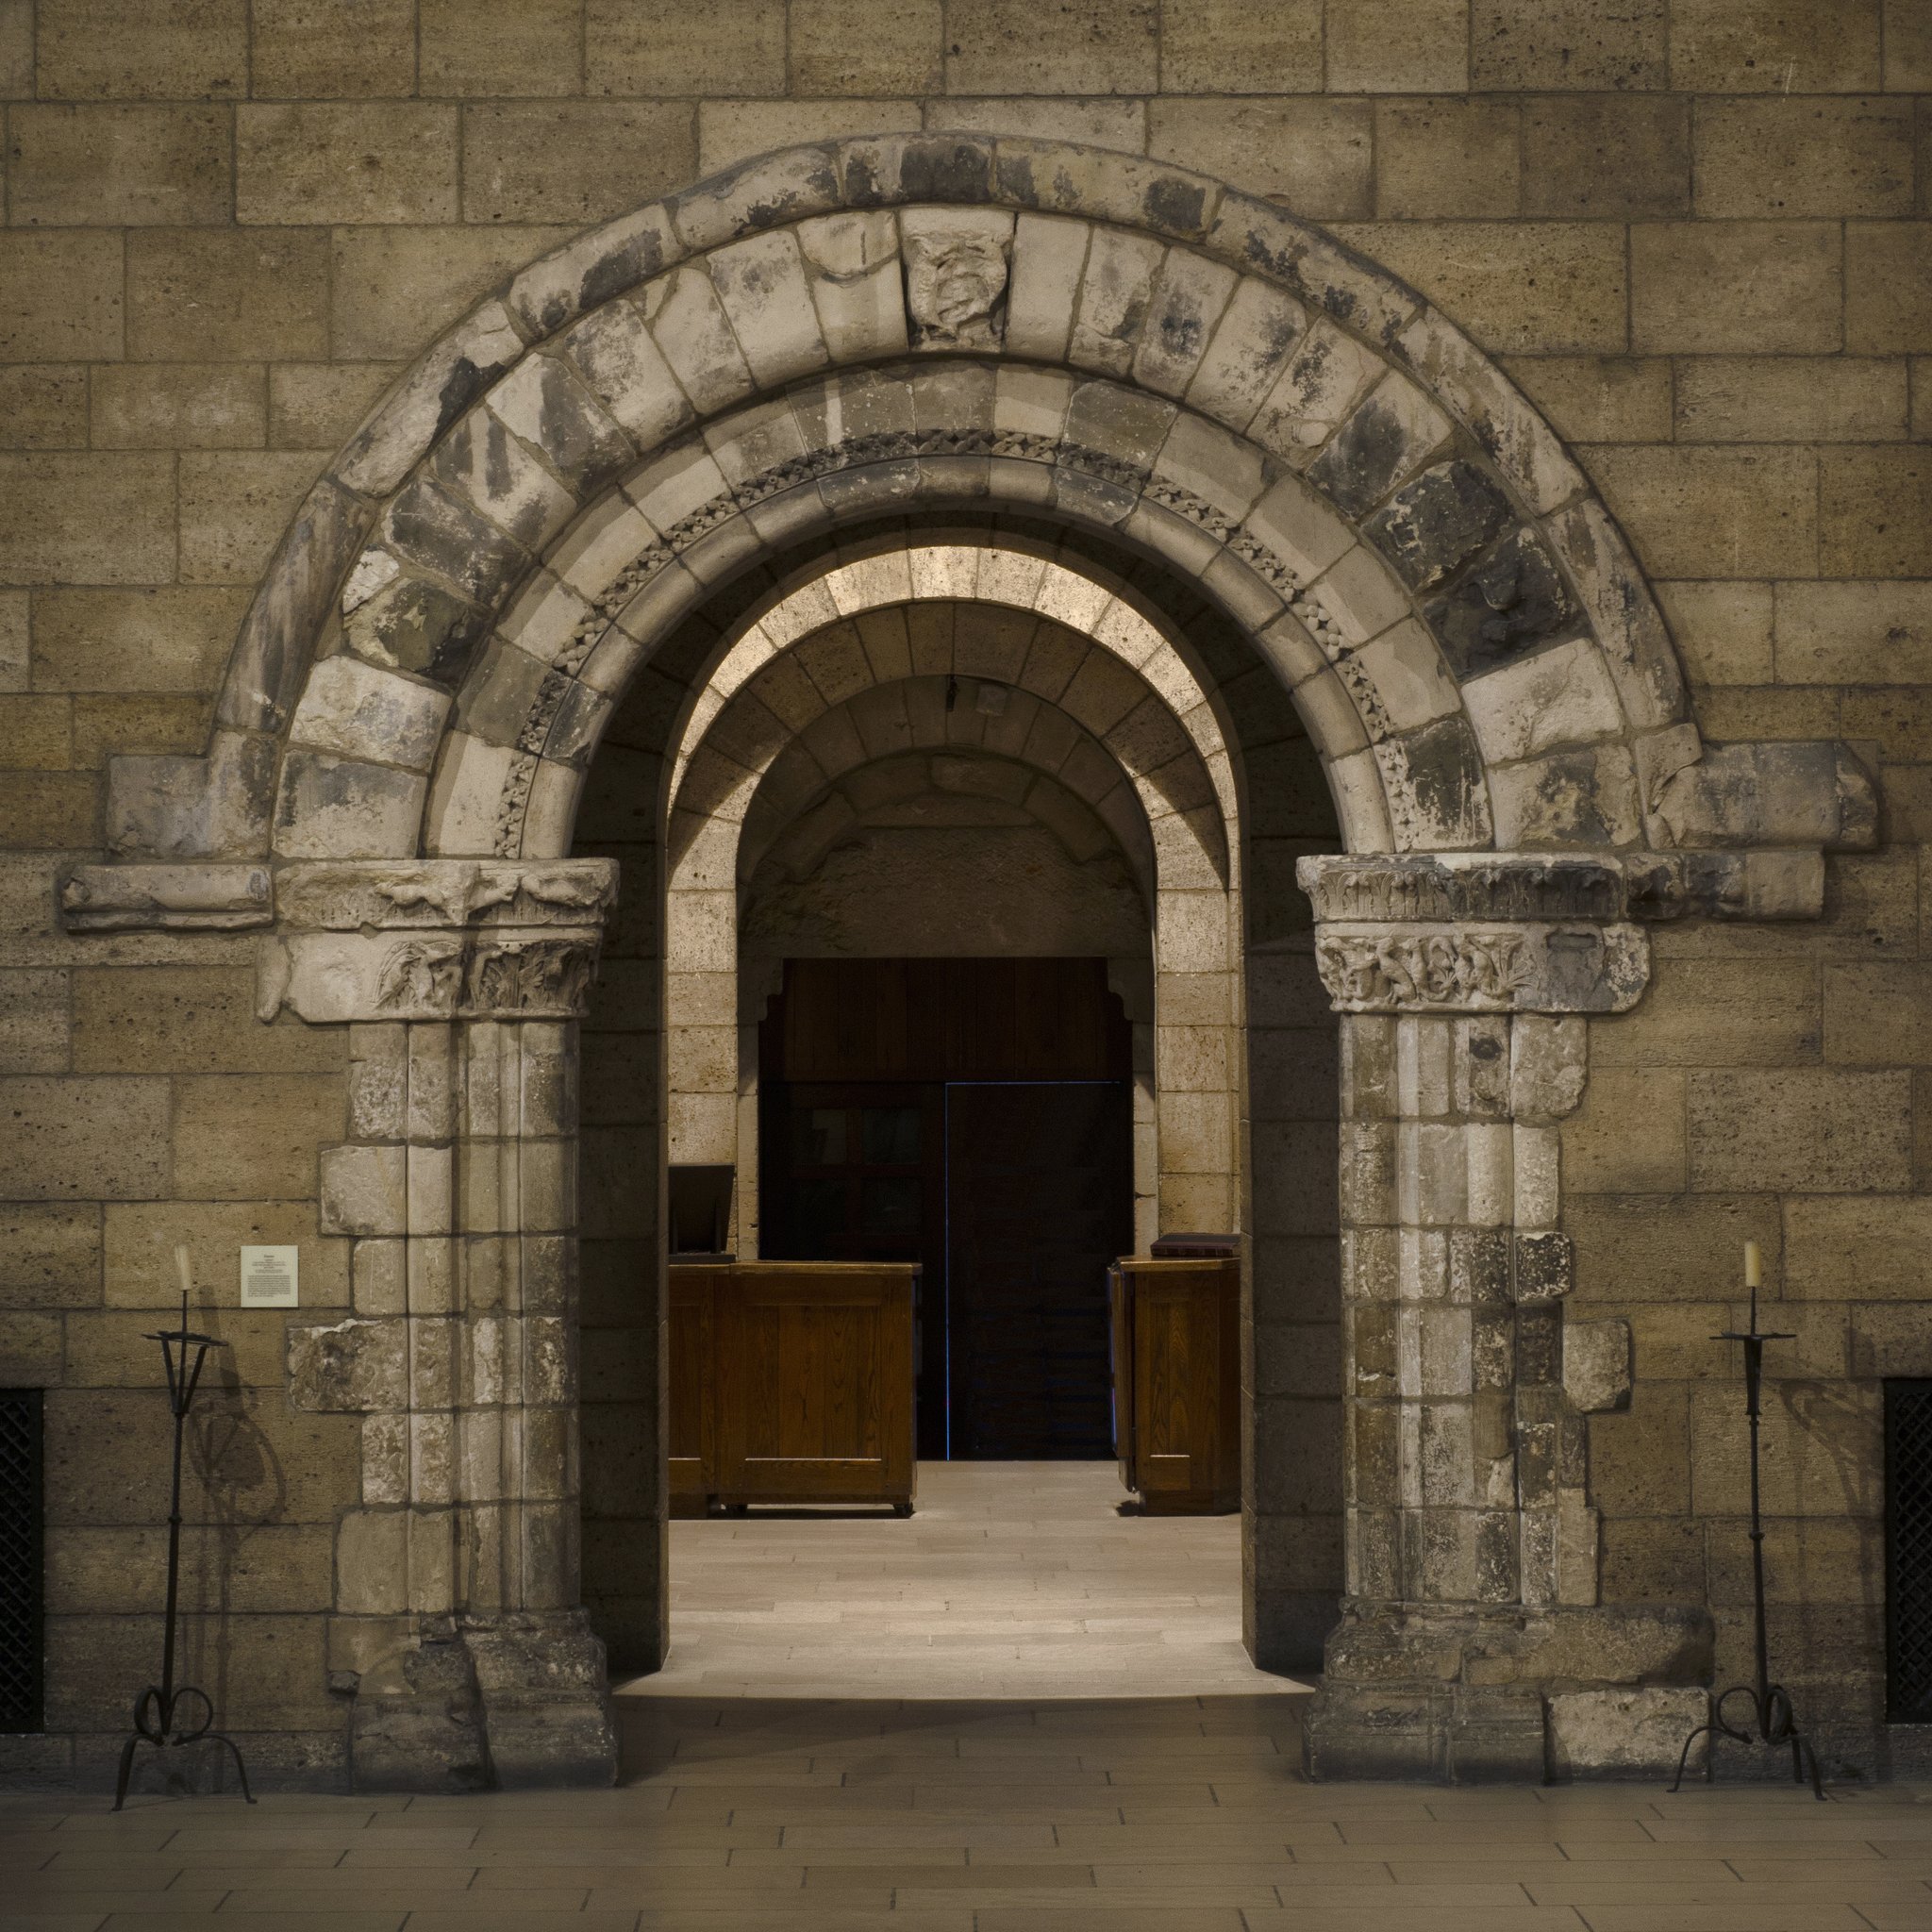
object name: portal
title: Doorway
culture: french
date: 1134-1166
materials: limestone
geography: france